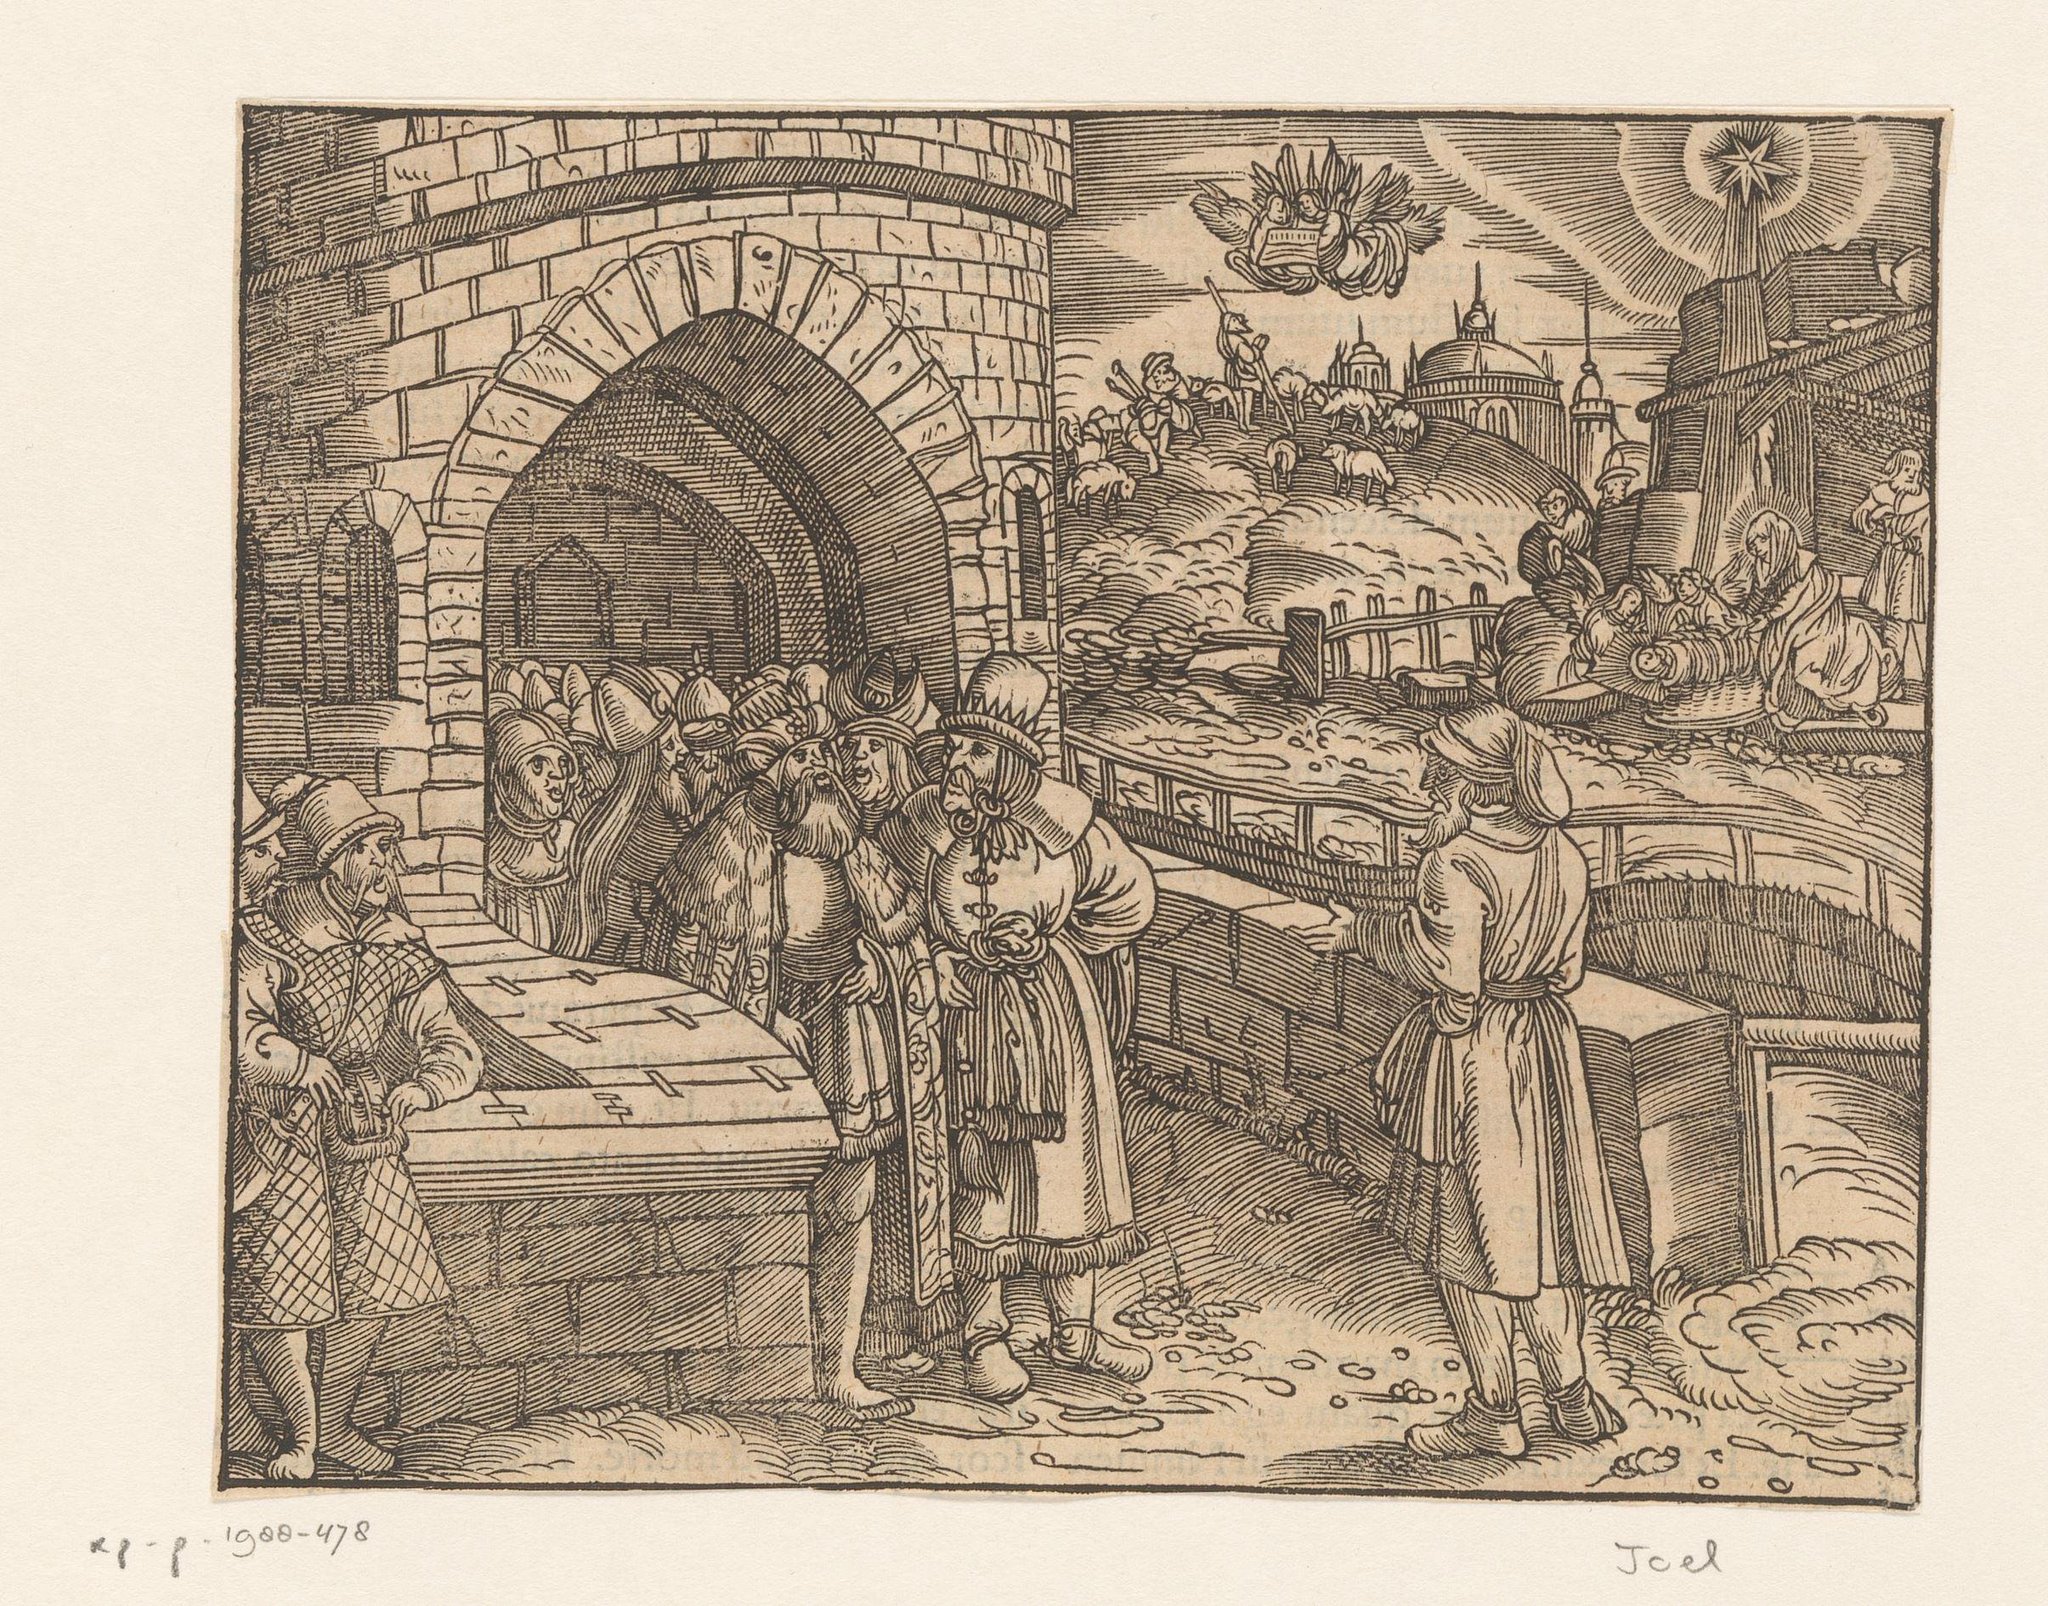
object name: print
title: Profeet Micha predikend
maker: Anonymous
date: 1534-1600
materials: paper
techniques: woodcut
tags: 11i(micah)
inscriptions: collector's mark: Lugt 2228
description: Prent afkomstig uit een onbekende publicatie.